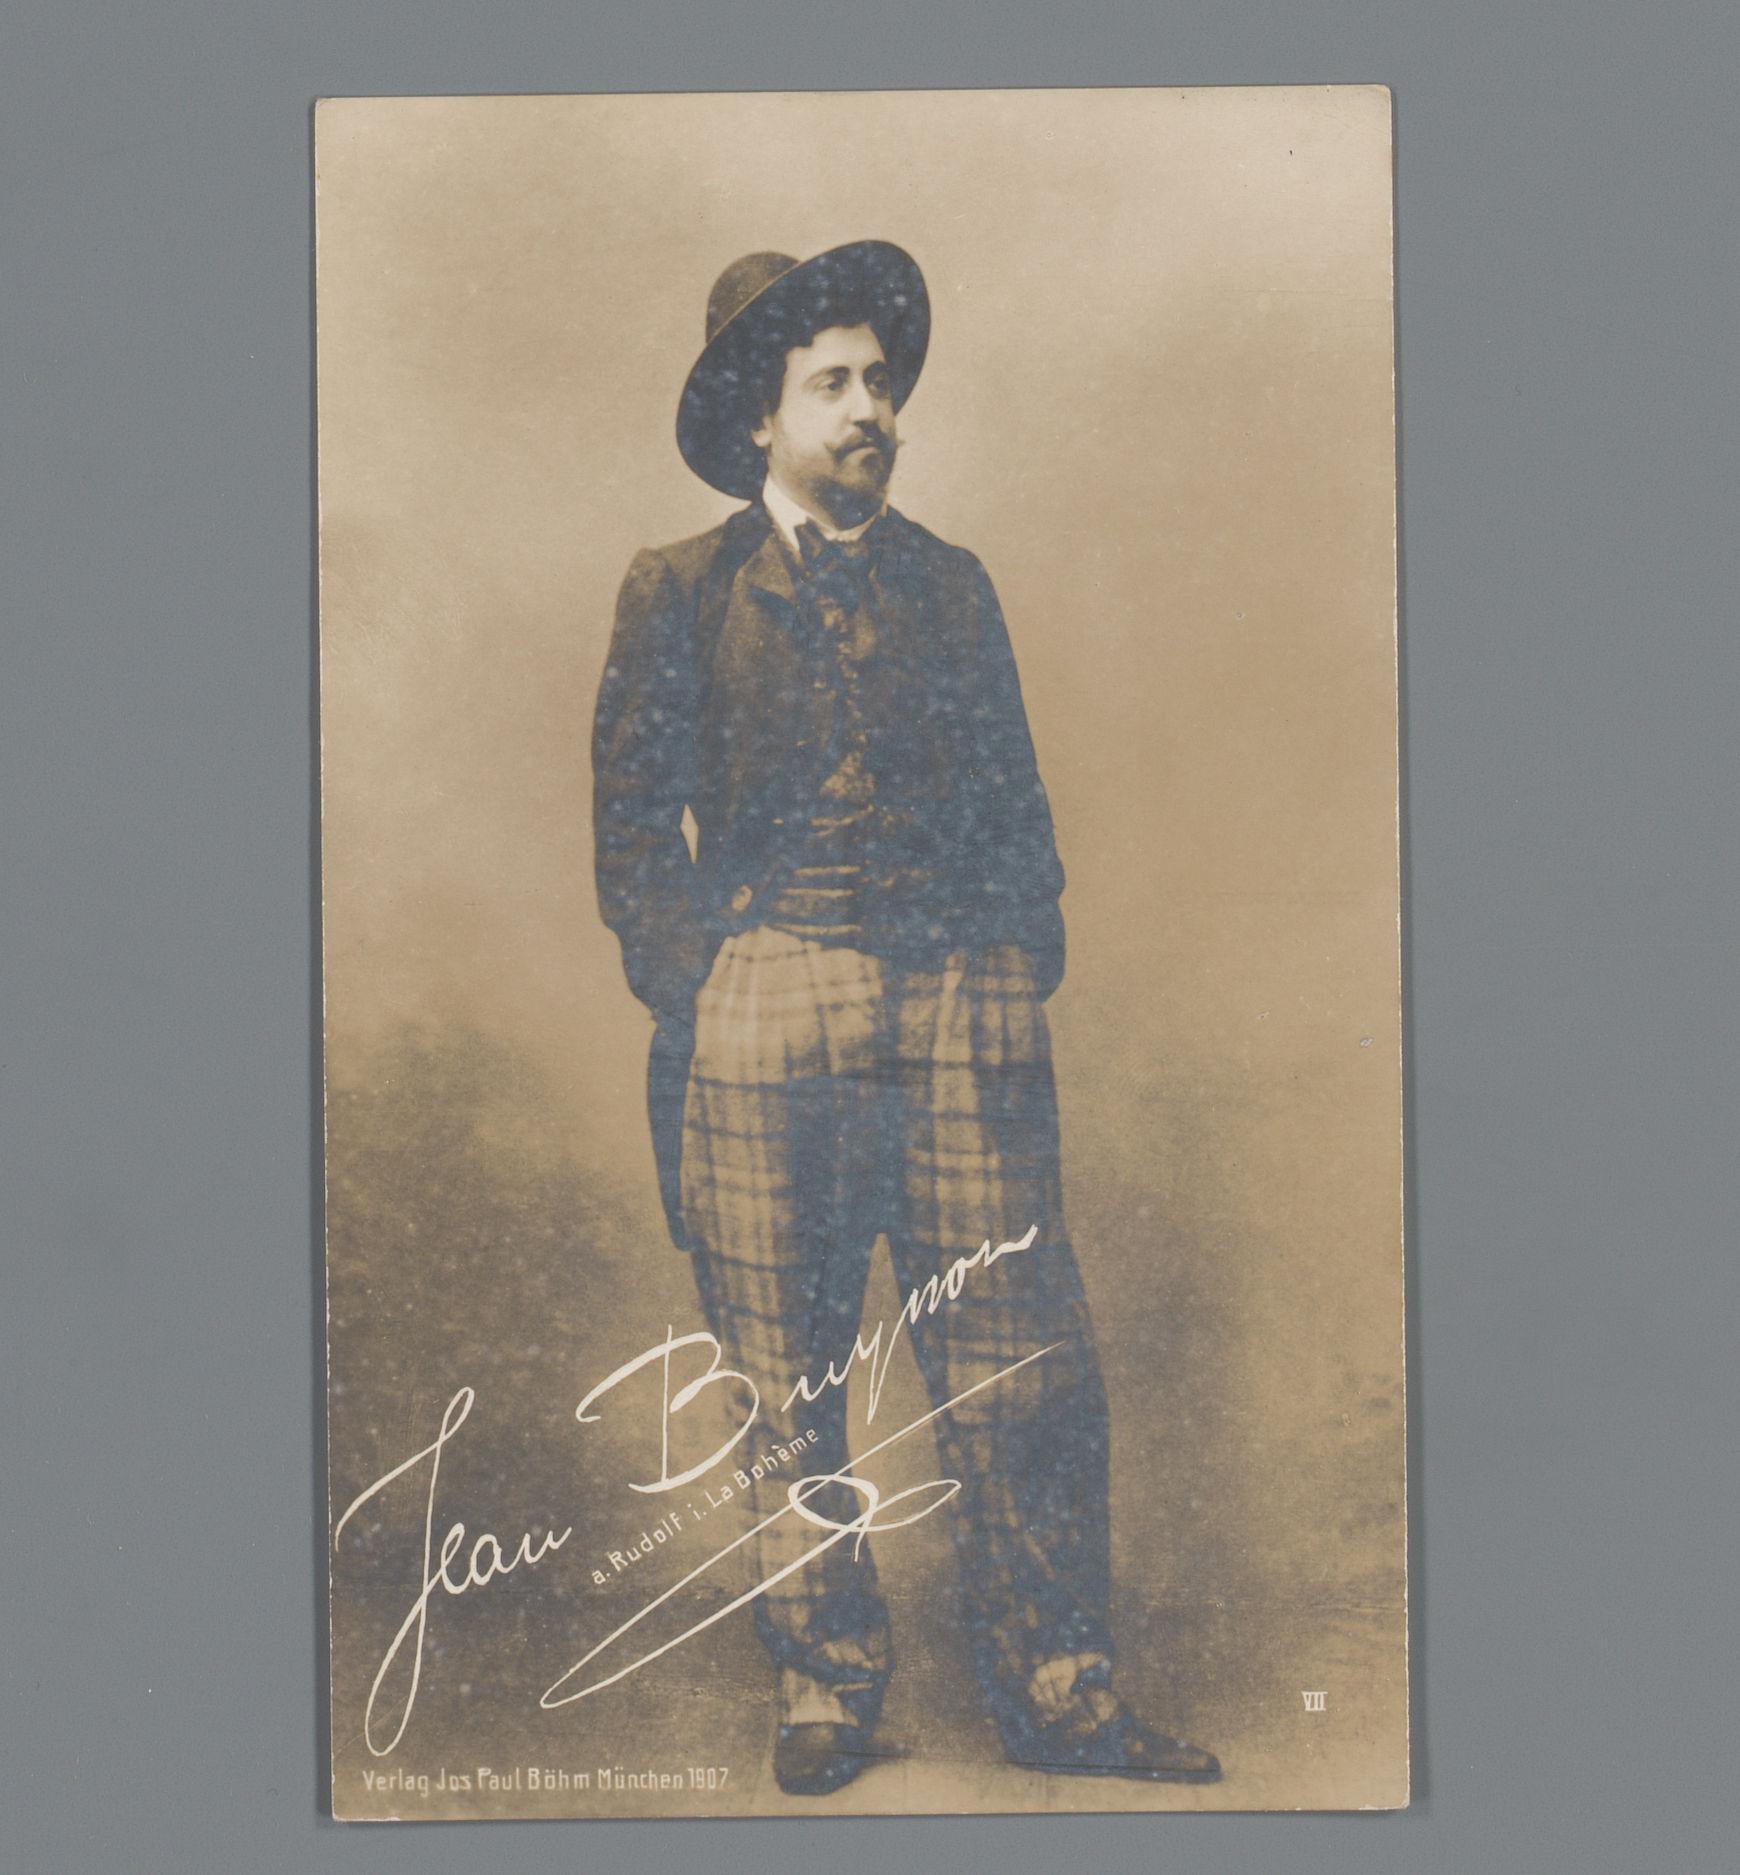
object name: ansichtkaart, prentbriefkaart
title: Jean Buysson a Rudolf i. La Bohème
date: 1907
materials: paper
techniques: gelatin silver print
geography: munich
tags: amsterdam, paris, historical persons (portraits and scenes from the life)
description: Portret van Jean Buysson als Rodolfo in La bohème.